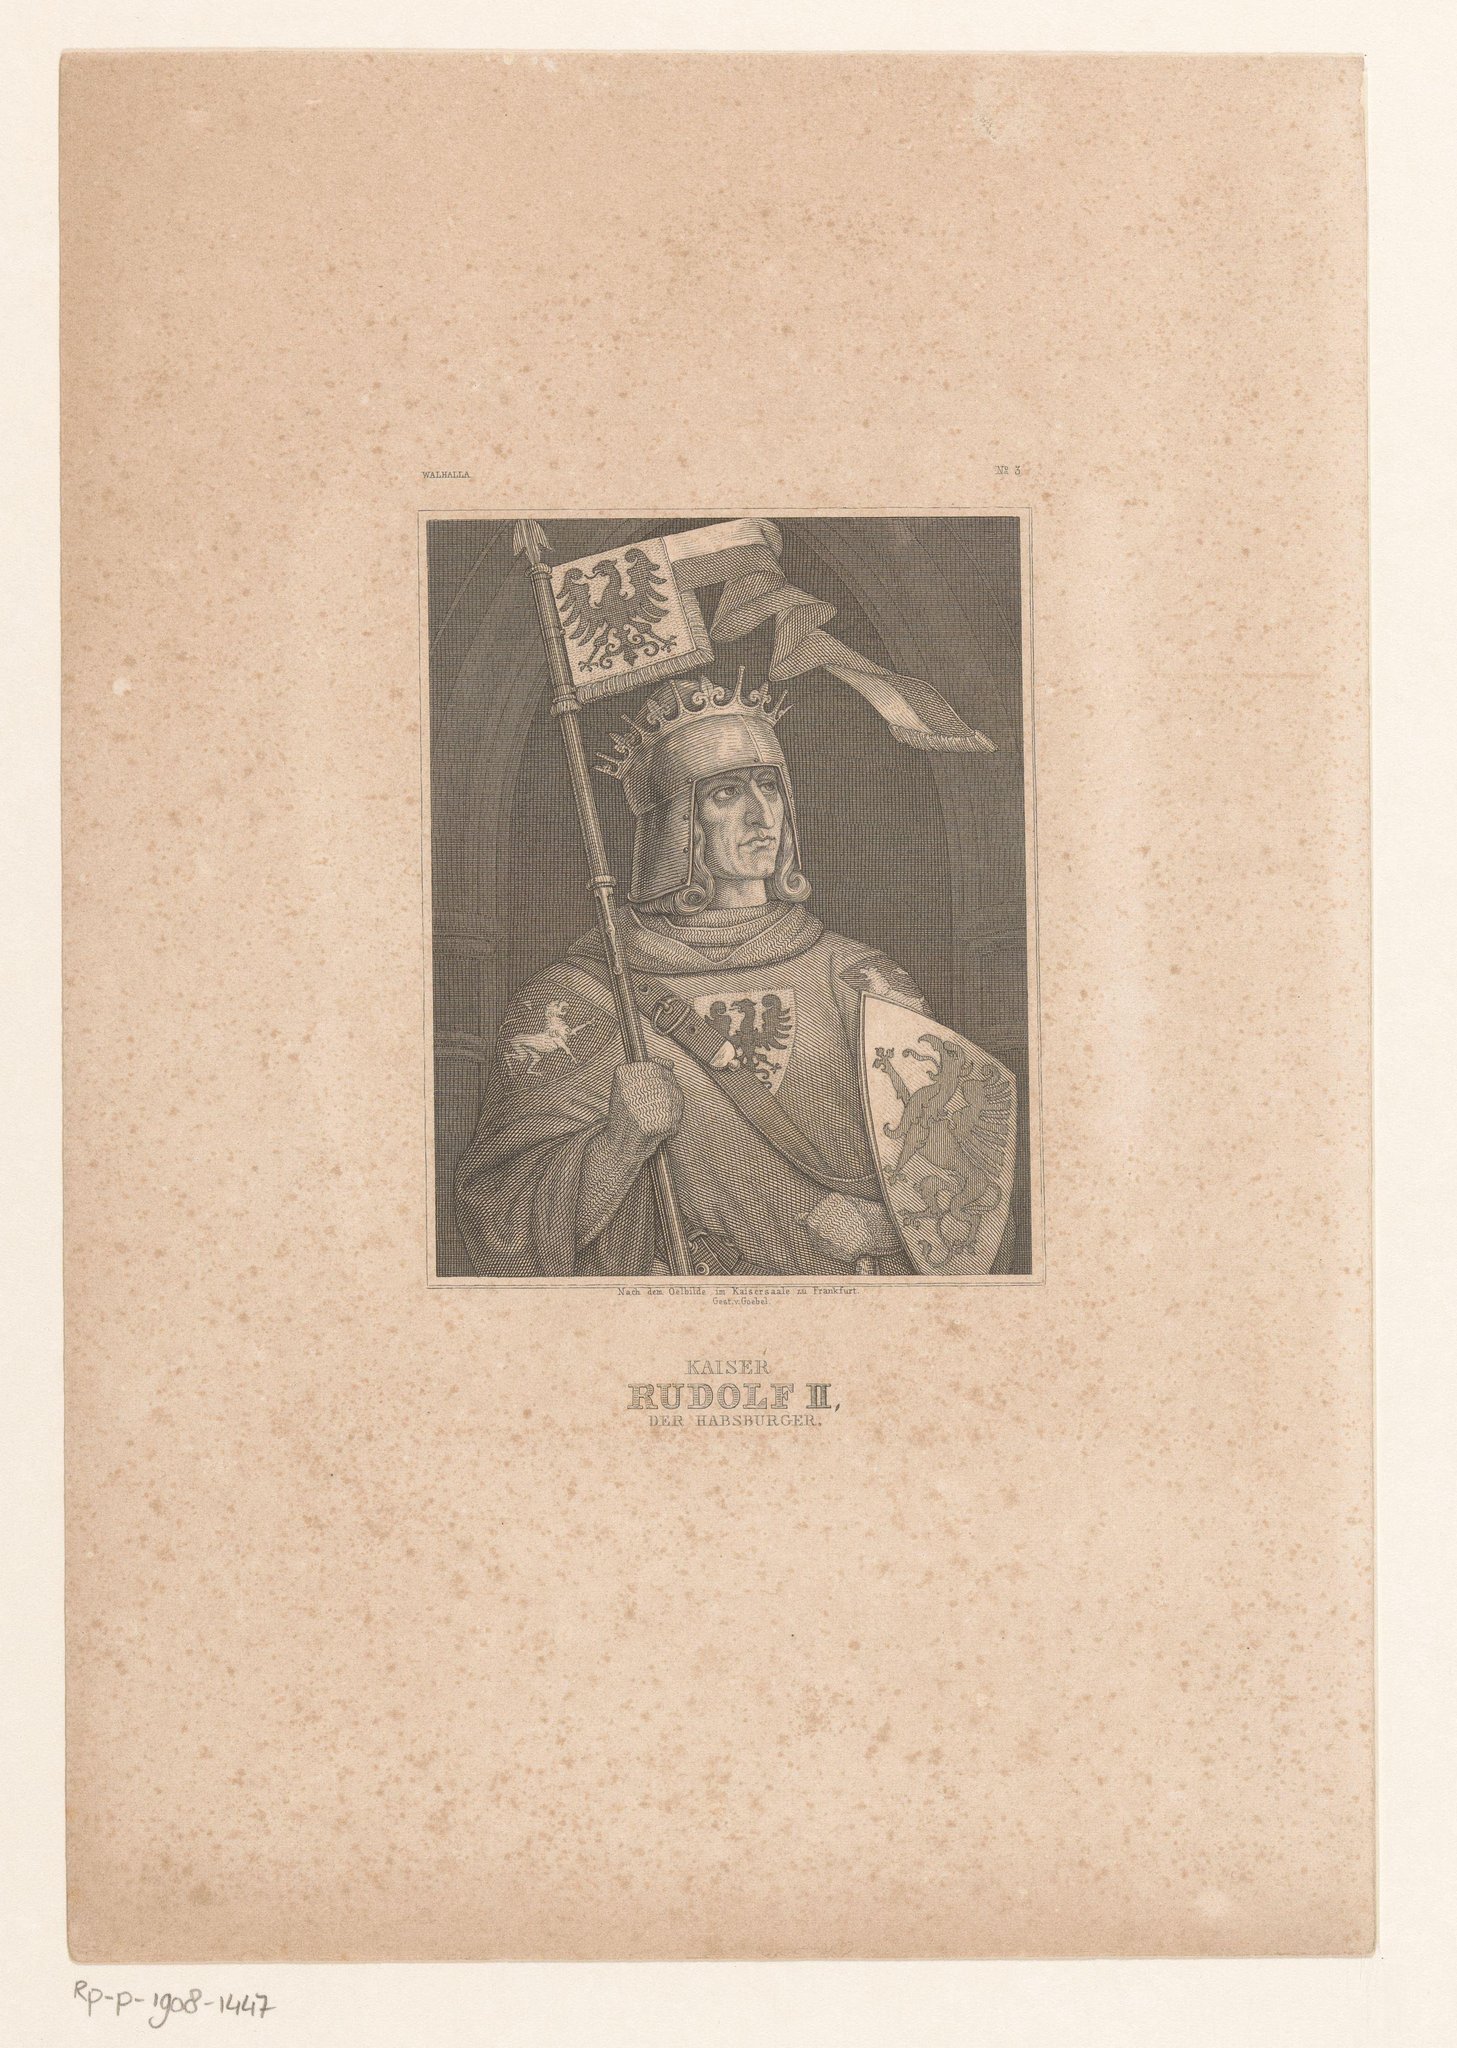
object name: print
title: Walhalla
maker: goebel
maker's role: print maker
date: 1852-1856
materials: paper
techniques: etching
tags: rudolf ii van habsburg (duits keizer), predatory birds: eagle, armour, historical persons, emperor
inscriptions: collector's mark: Lugt 2228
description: Afkomstig uit de portretserie 'Walhalla, eine Gallerie der Bildnisse der Zierden des Menschengeschlechts', uitgegeven tussen 1852-1856.